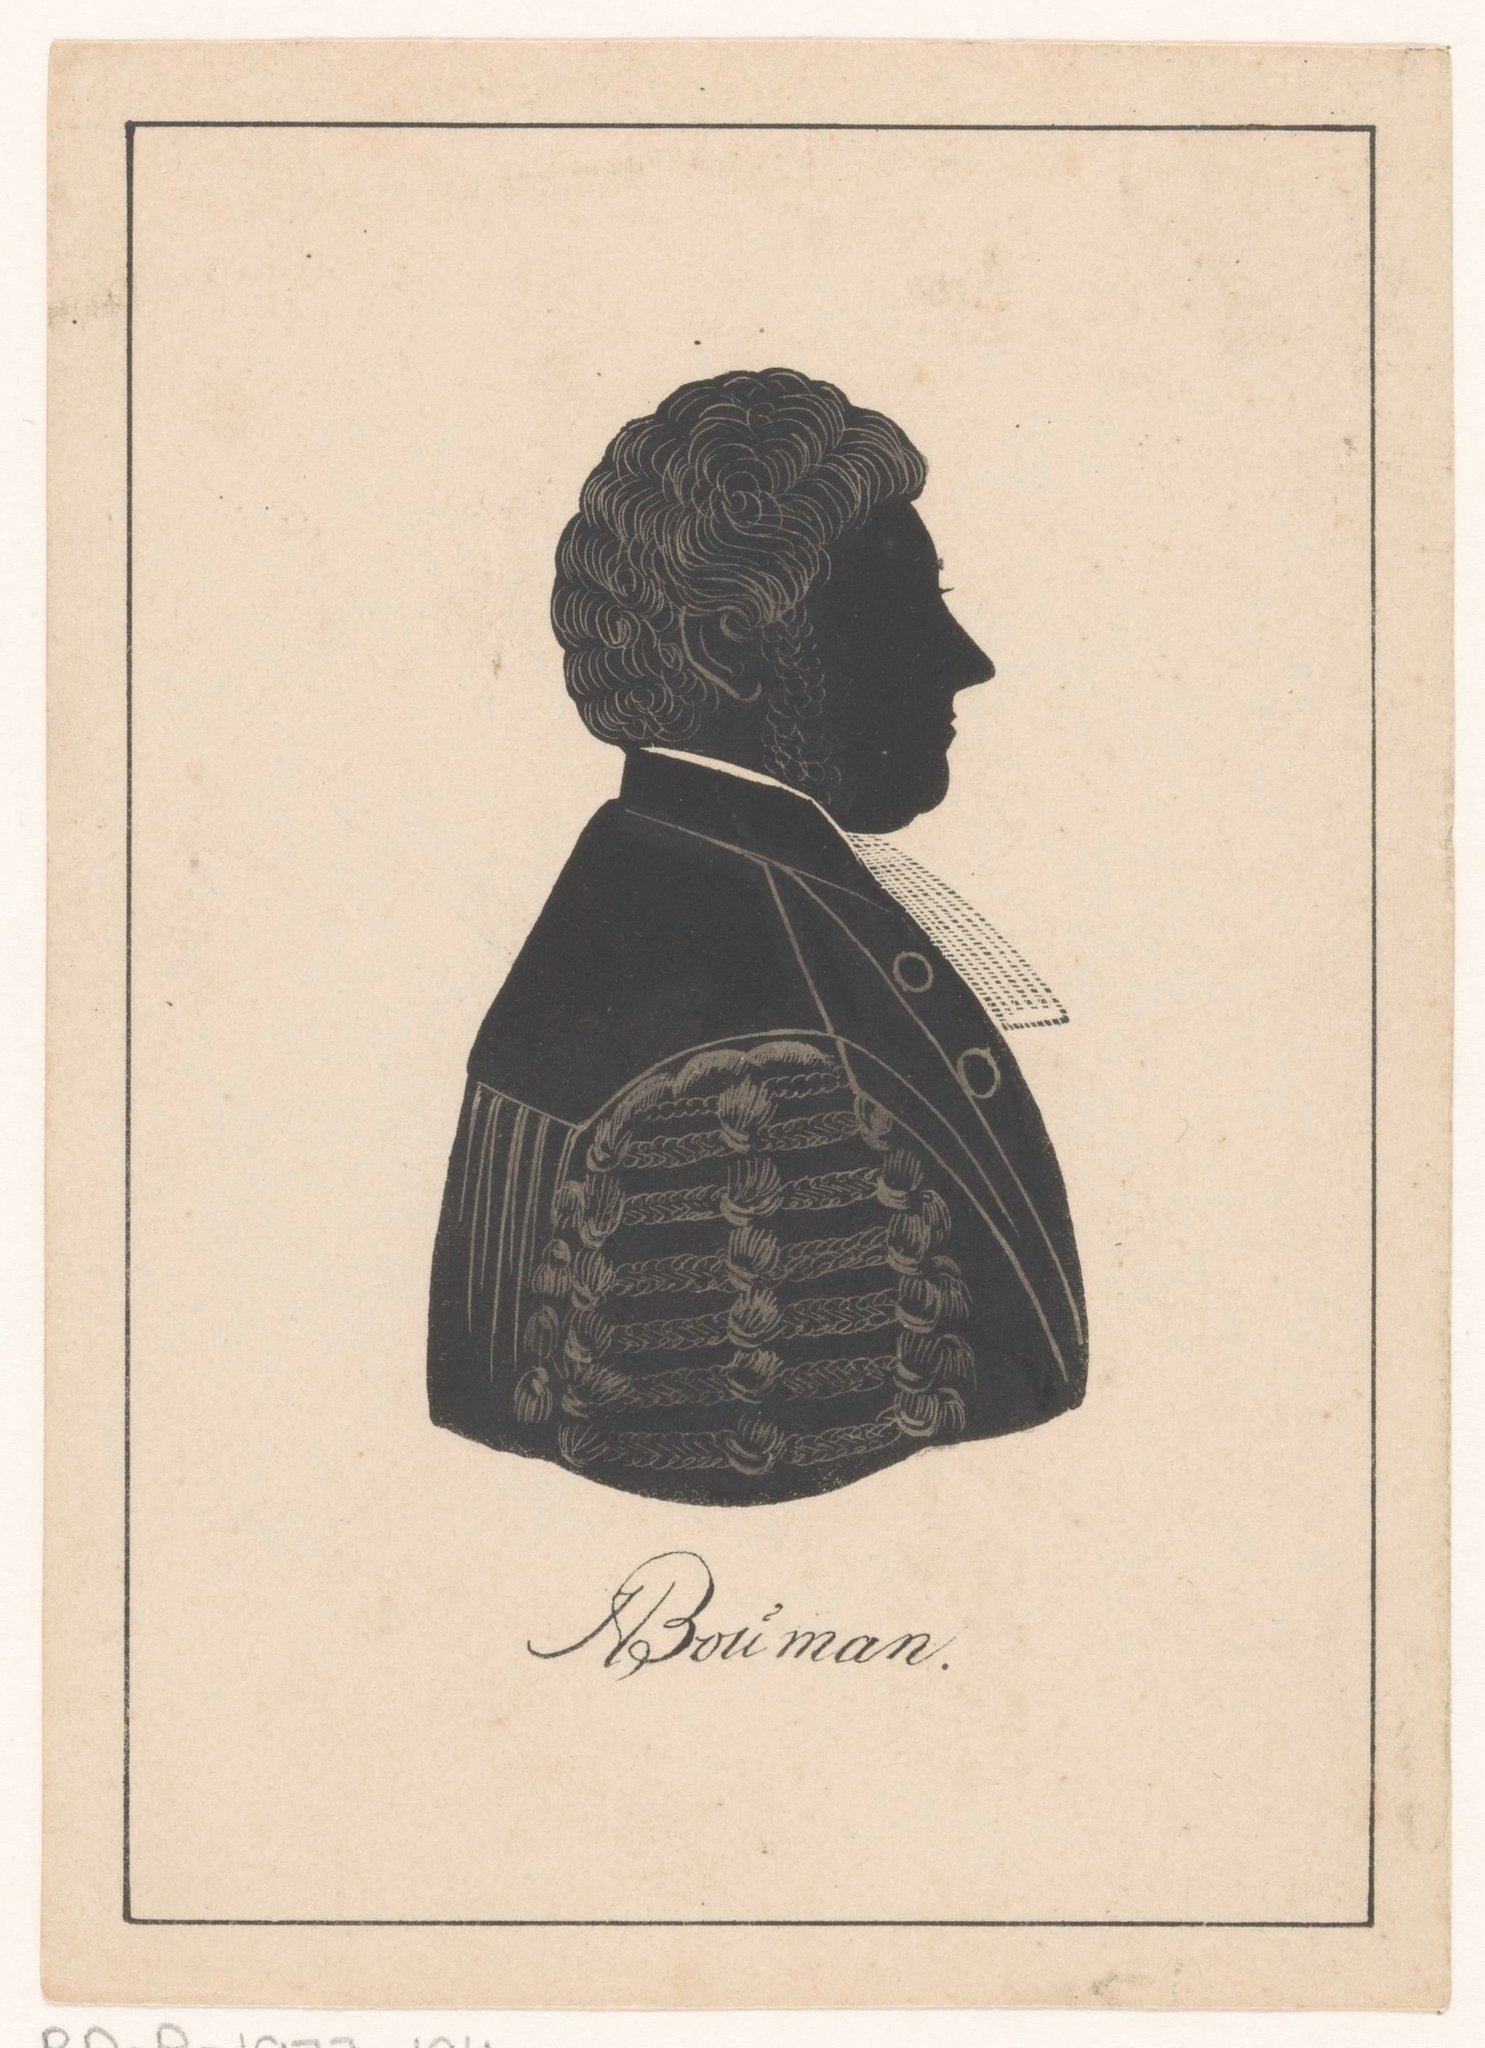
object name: print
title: Silhouetportret van Herman Bouman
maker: Anonymous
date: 1860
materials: paper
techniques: hand coloring, lithograph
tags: historical persons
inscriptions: collector's mark: Lugt 2228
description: Onder het portret de signatuur van de geportretteerde.